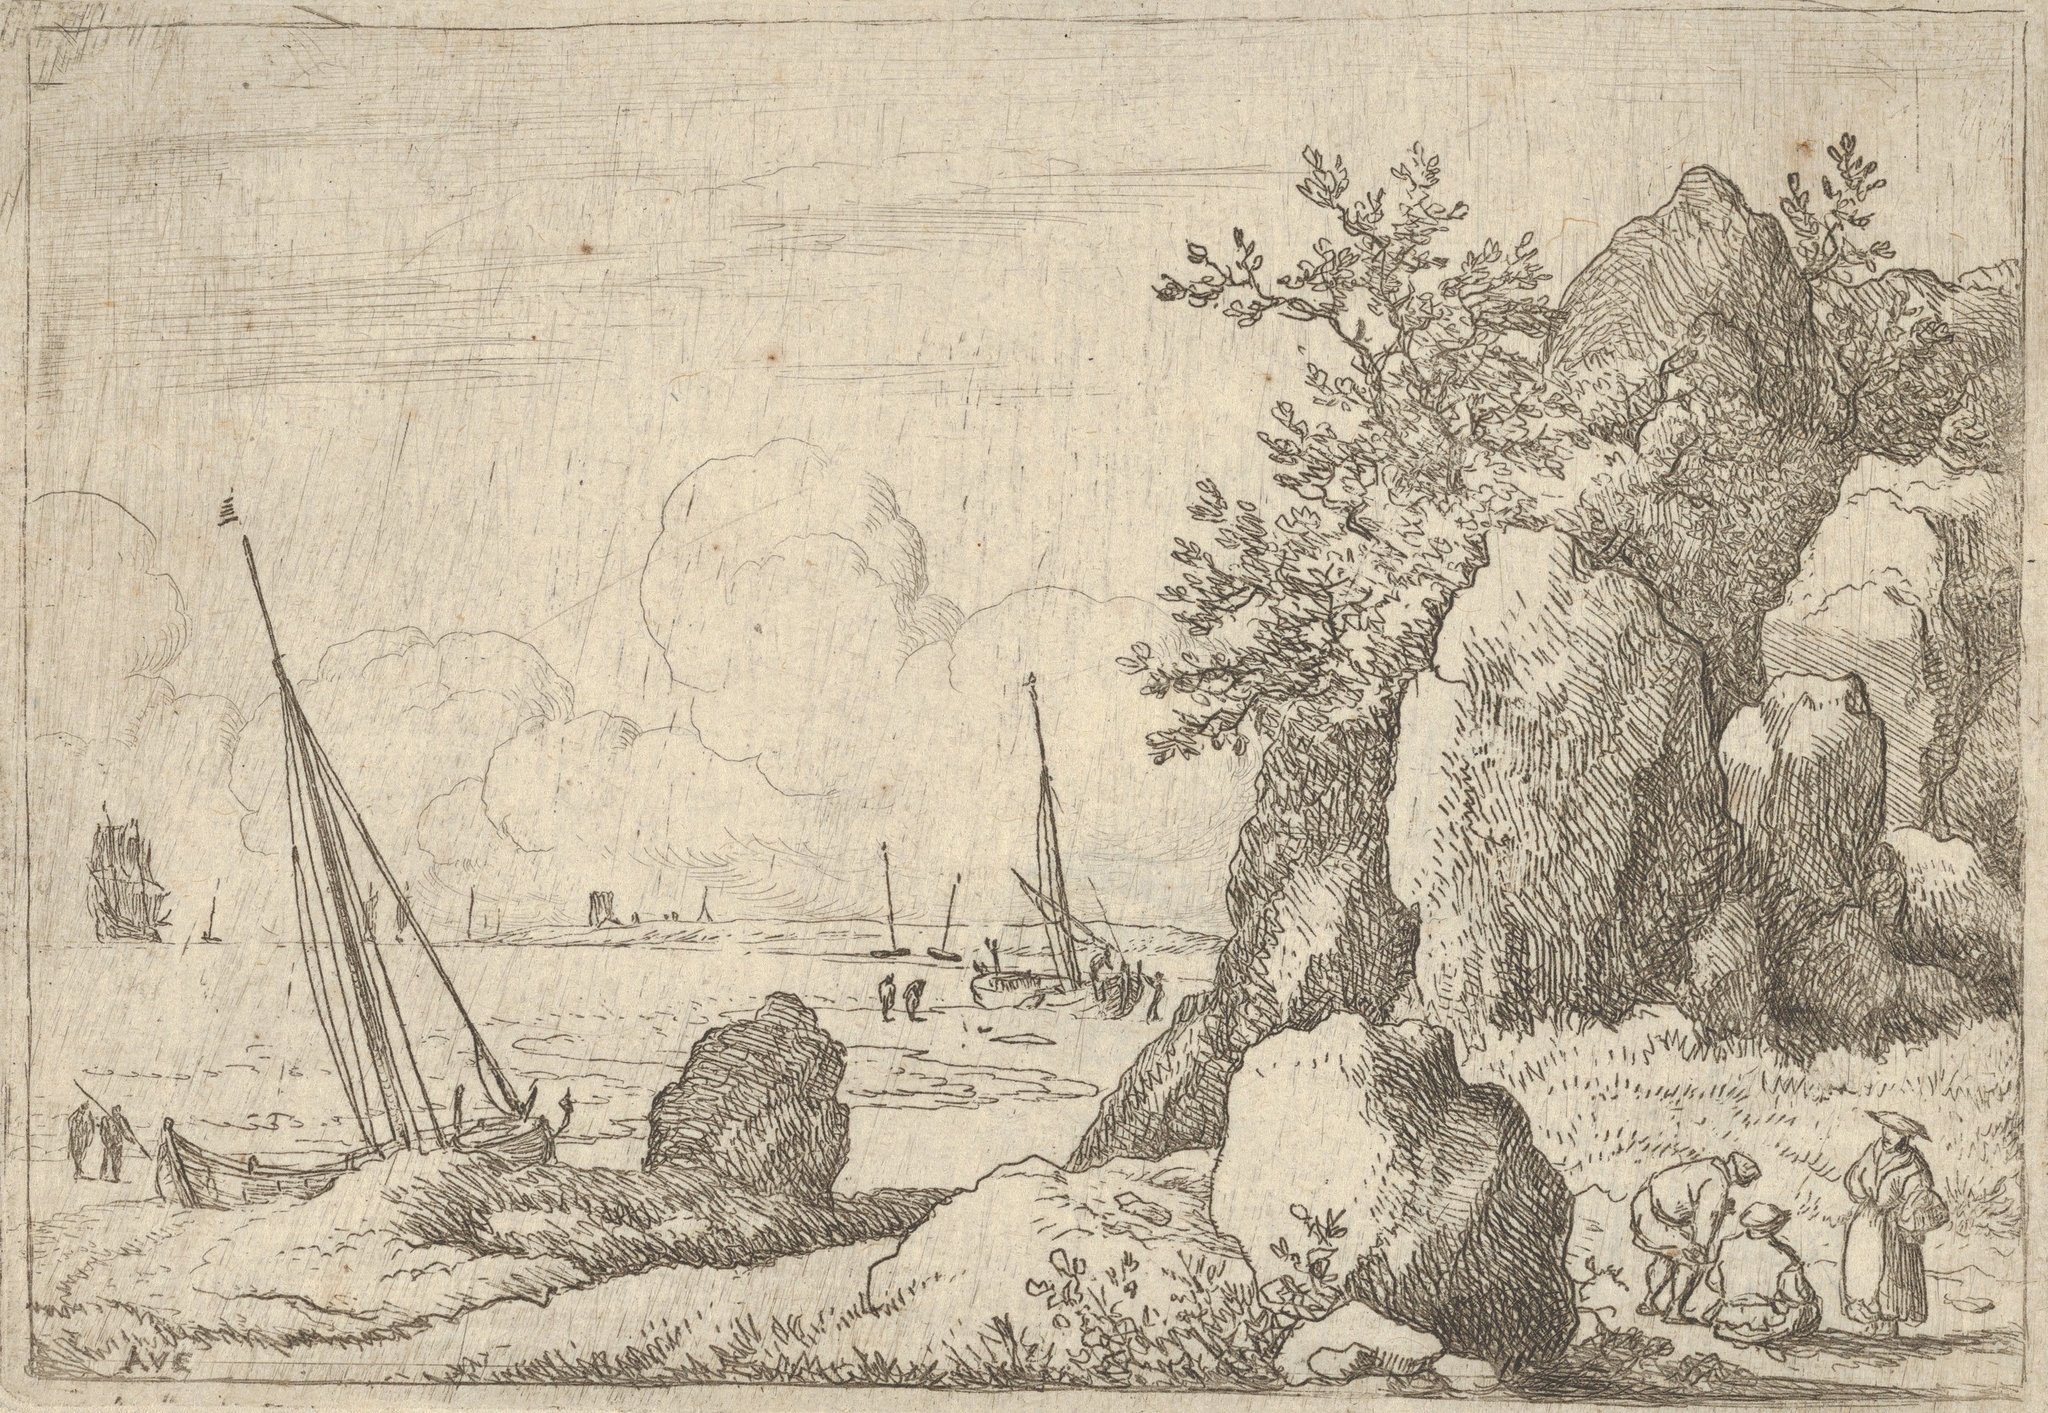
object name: print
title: Sea Piece with Three Figures to the Right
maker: allart van everdingen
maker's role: artist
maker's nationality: dutch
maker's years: 1621-1675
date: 1621-1675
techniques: engraving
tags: human figures,trees,boats